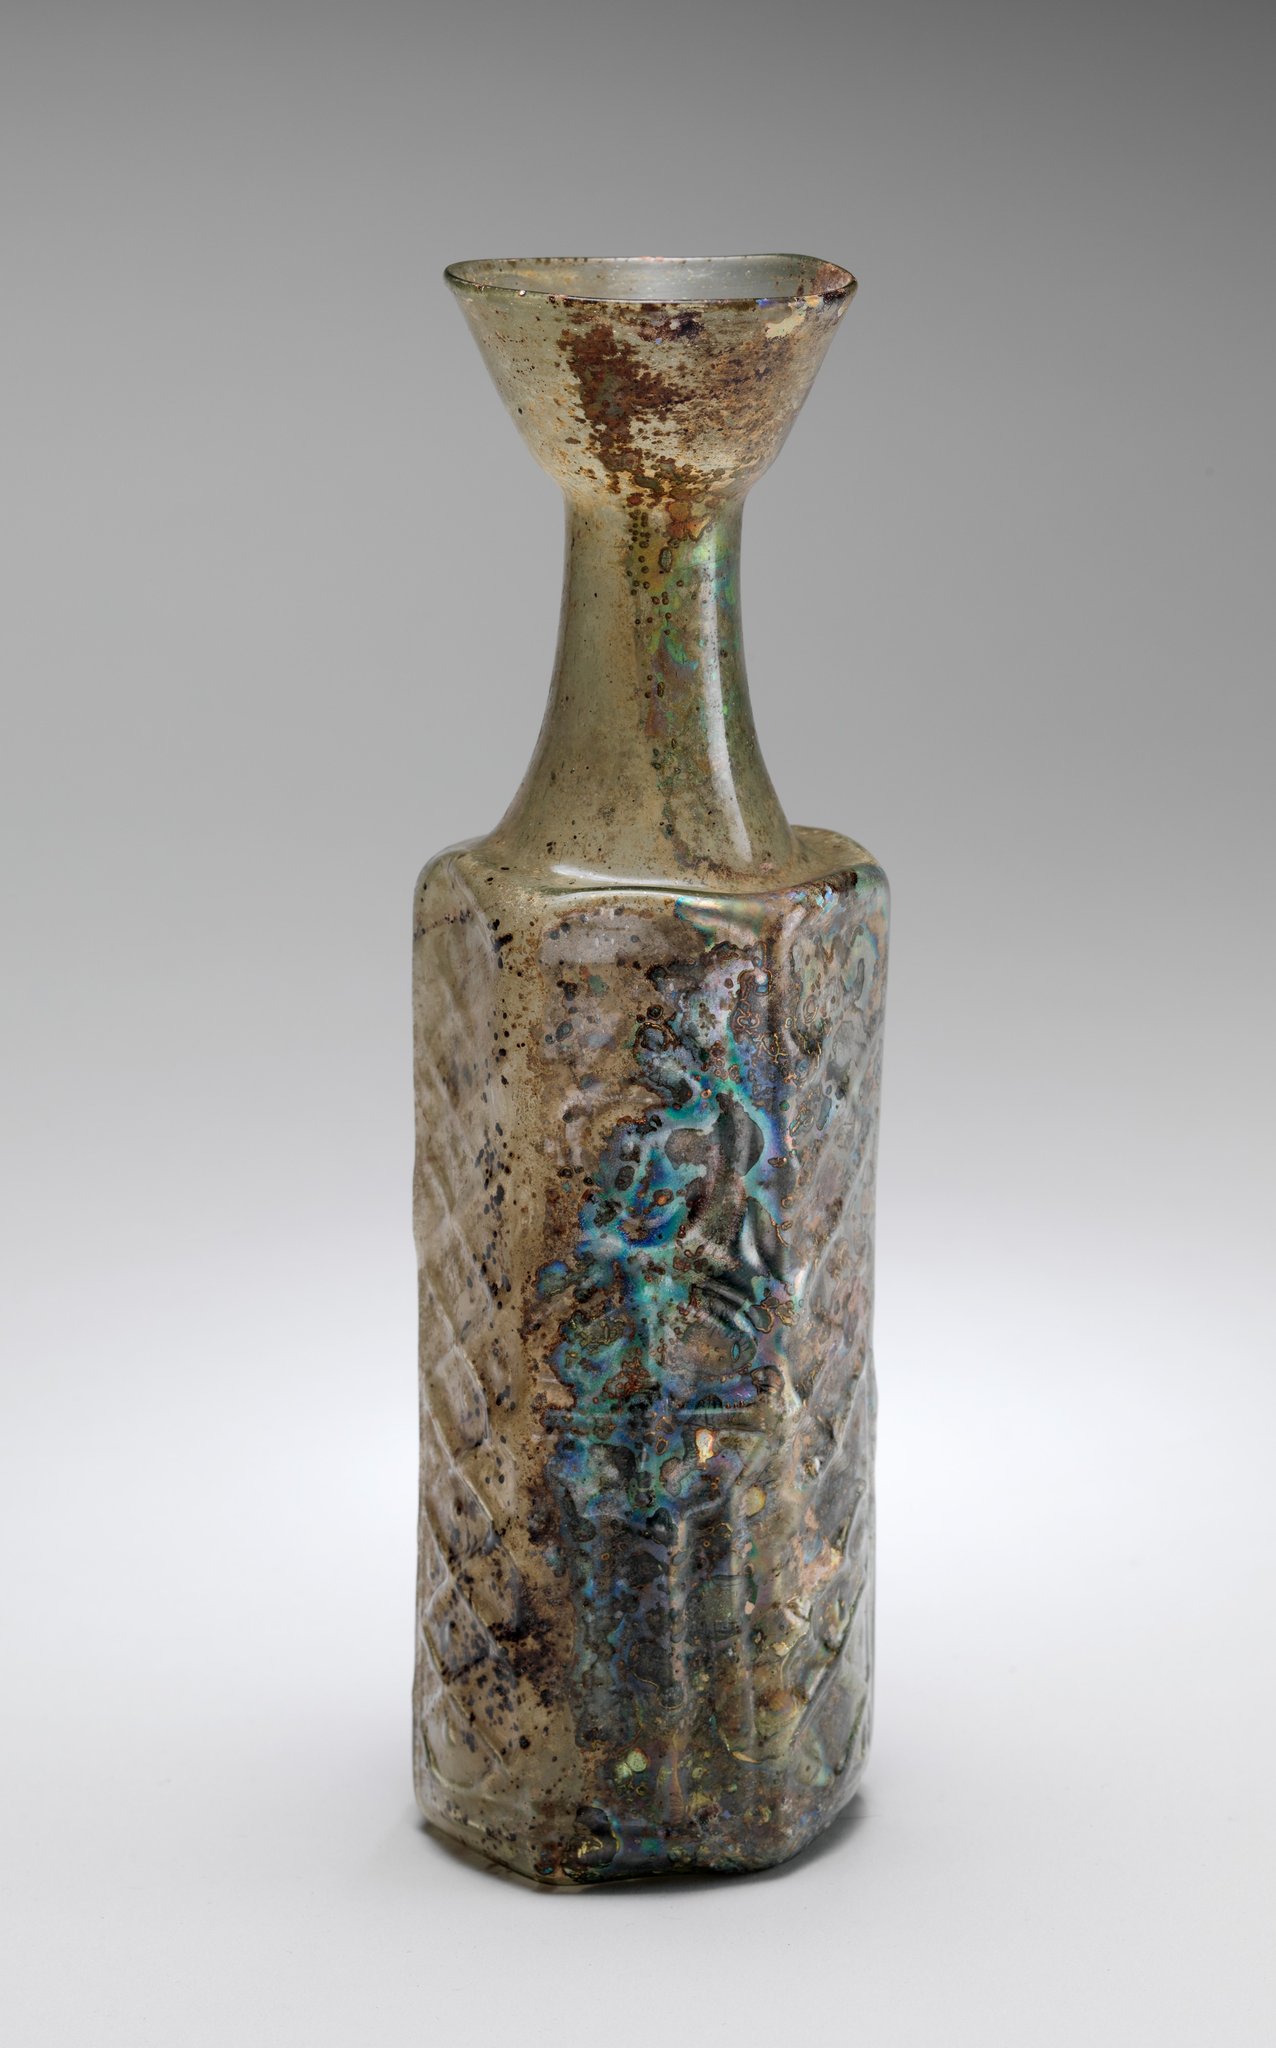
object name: bottle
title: Yellow-Green Hexagonal Glass Bottle with a Stylite Saint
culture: byzantine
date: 434-700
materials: glass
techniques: molding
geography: syria